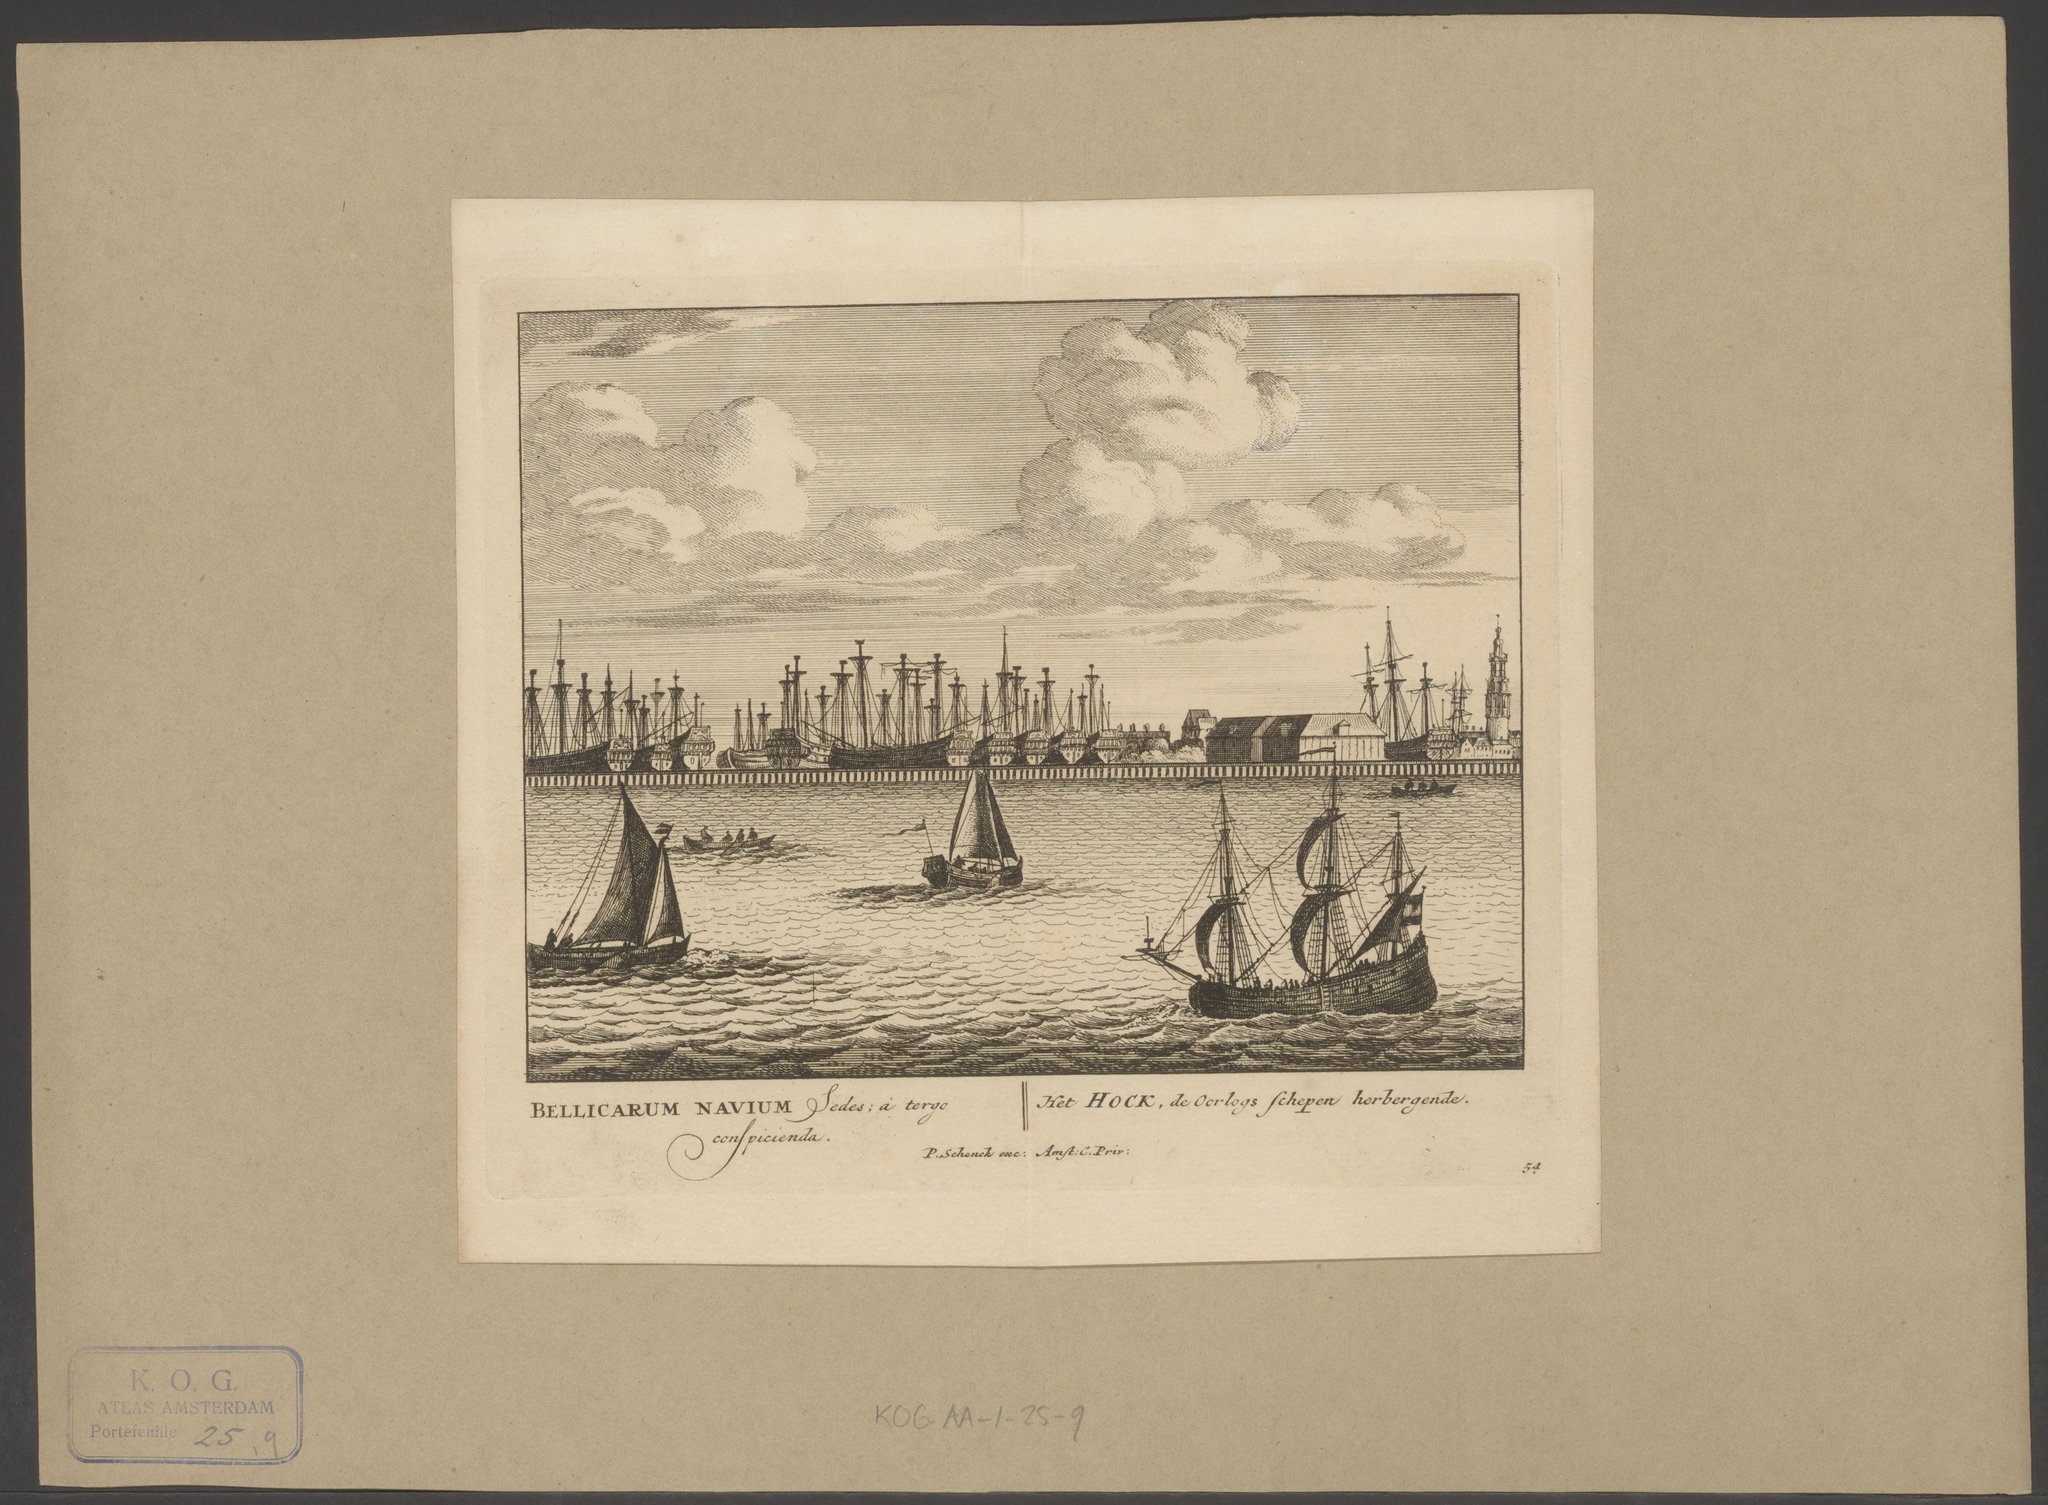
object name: print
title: Gezicht op de Kattenburgergracht te Amsterdam met de ligplaats voor schepen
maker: Anonymous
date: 1710-1711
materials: paper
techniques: engraving, etching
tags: city-view in general; 'veduta', shipyard, shipdock - cc - more than one ship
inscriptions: collector's mark: ‘25.9’ Lugt 1641b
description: Andere staat van prent ook gebruikt in: 100 Afbeeldinge der voornaamste gebouwen van Amsterdam. Amsterdam, Pieter Schenk (I), [1710-1711]. En in: 100 Afbeeldinge der voornaamste gebouwen van Amsterdam. Amsterdam, Barent Greve, [1757-1766].